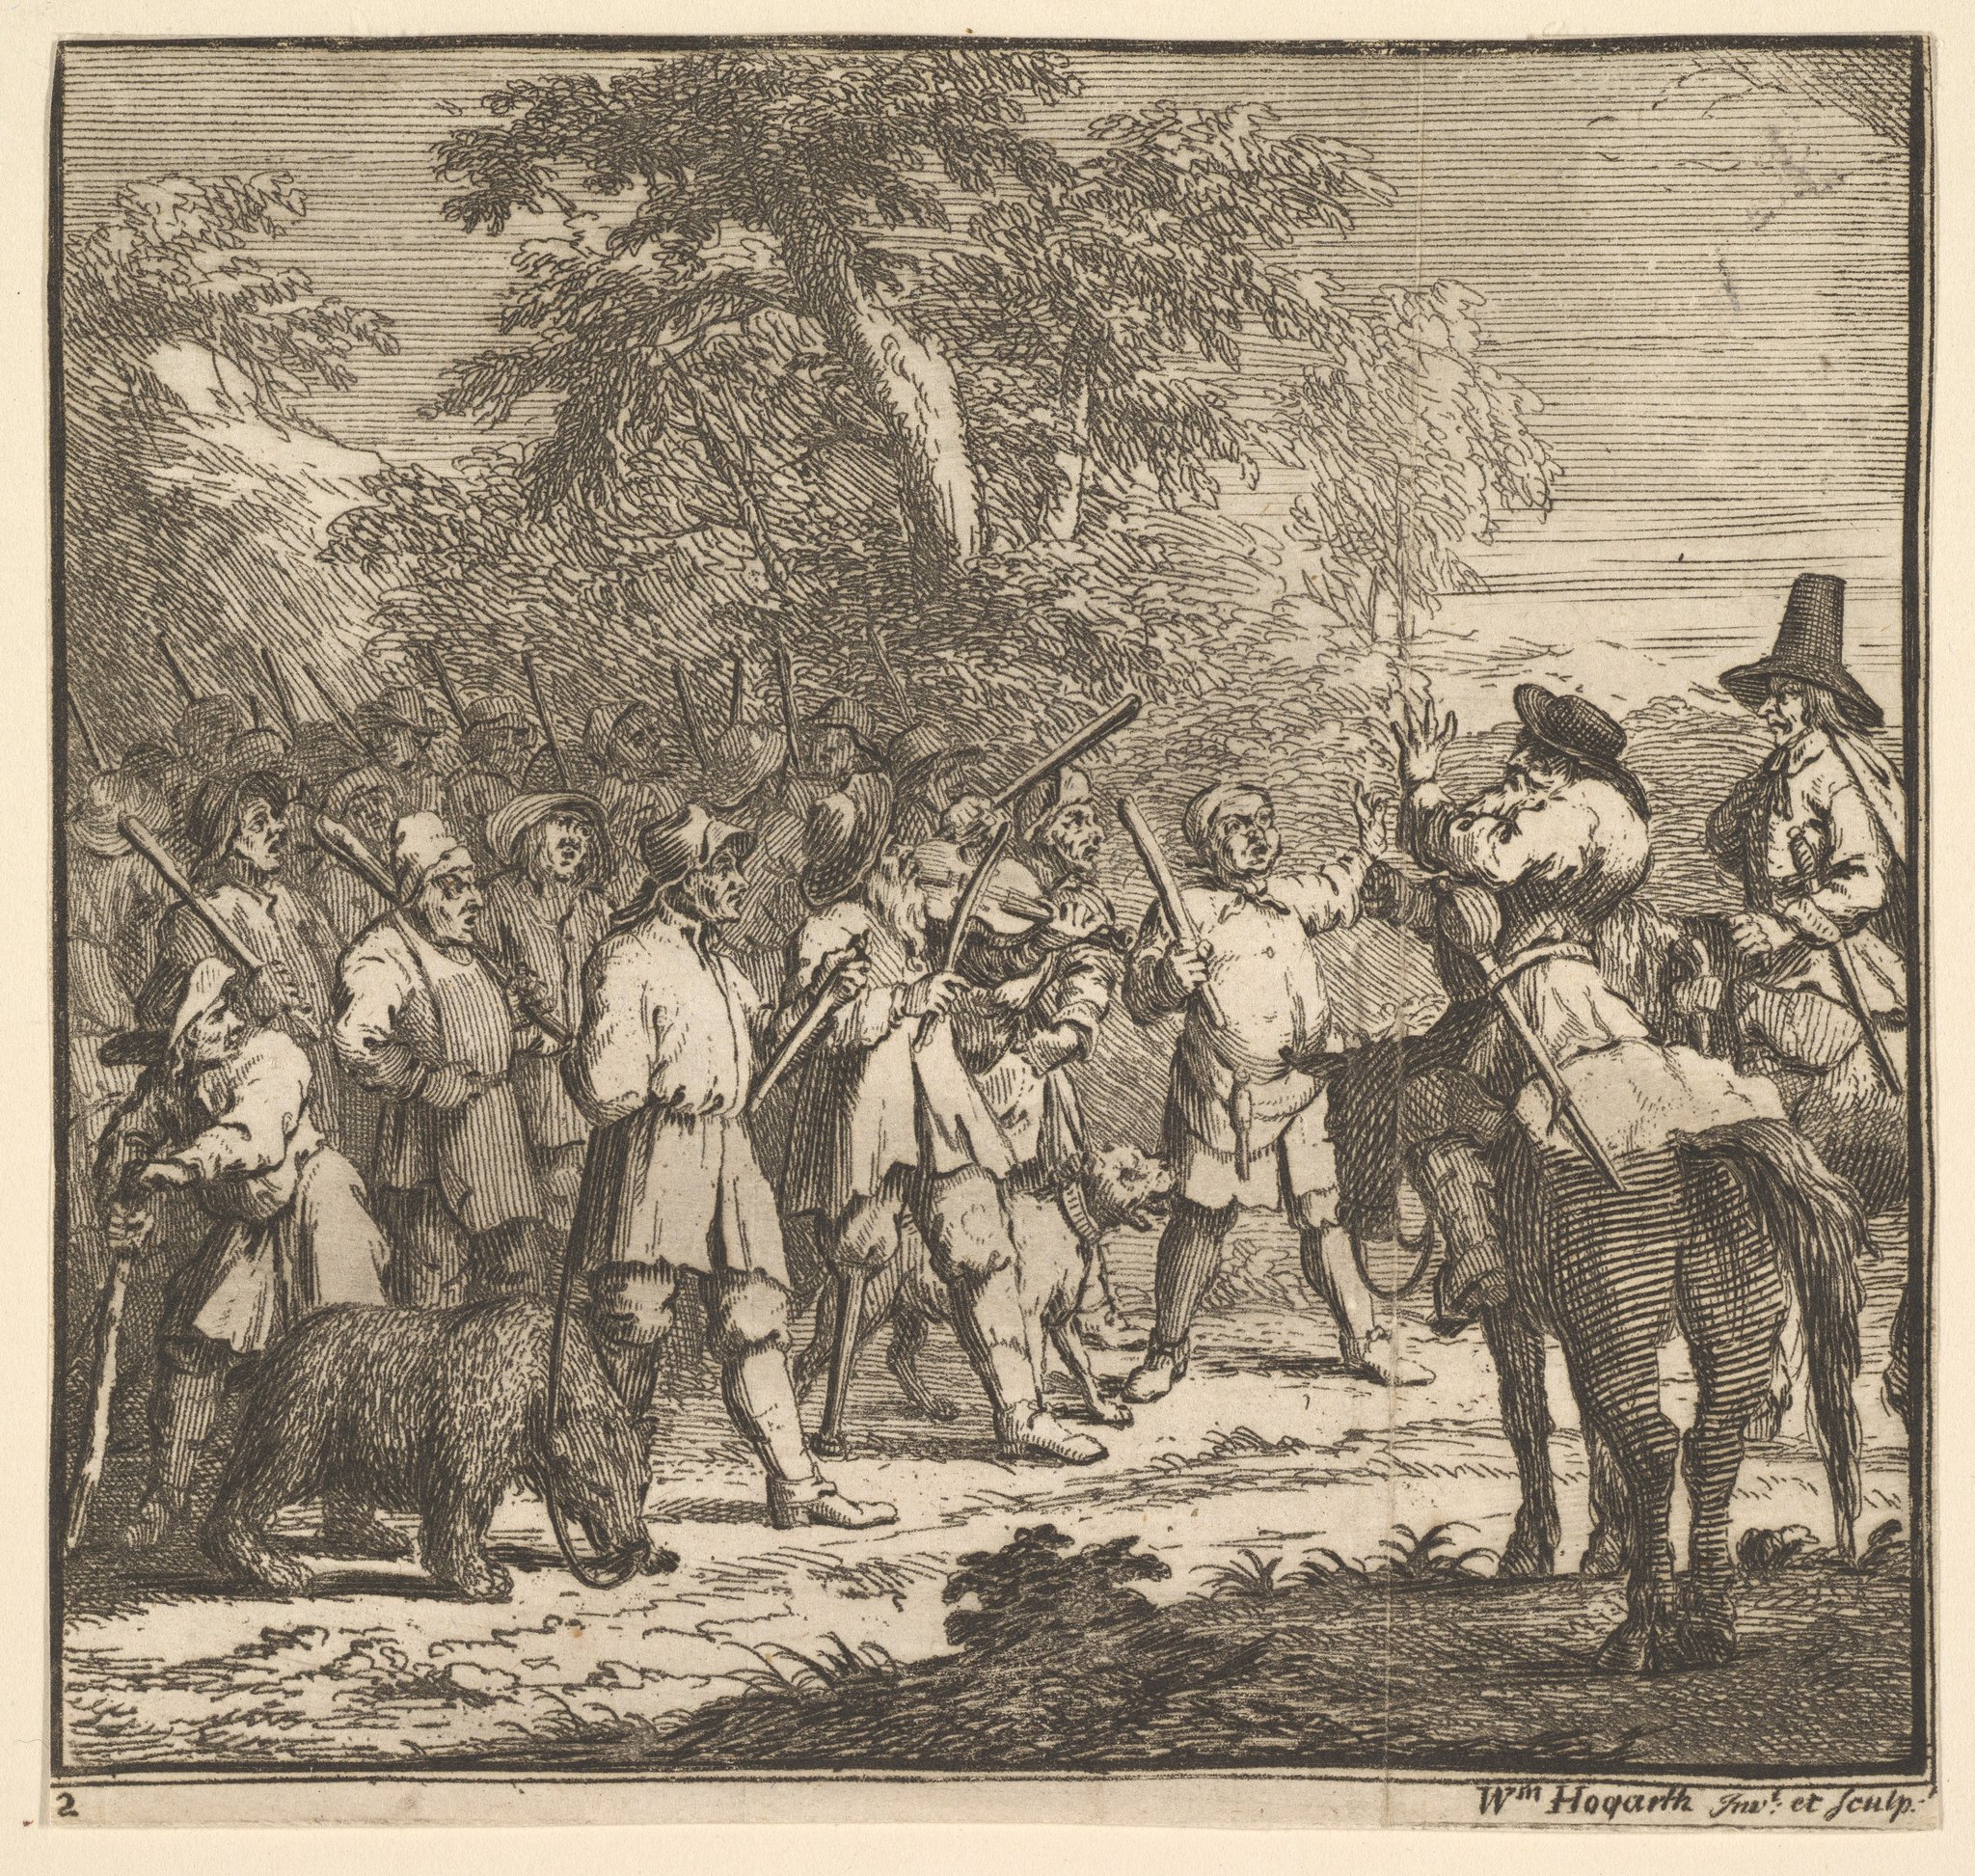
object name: print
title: Hudibras First Adventure (Seventeen Small Illustrations for Samuel Butler's Hudibras, no. 2)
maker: william hogarth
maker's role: artist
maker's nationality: british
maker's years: 1697-1764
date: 1721-1726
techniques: engraving, etching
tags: animals,men,horses